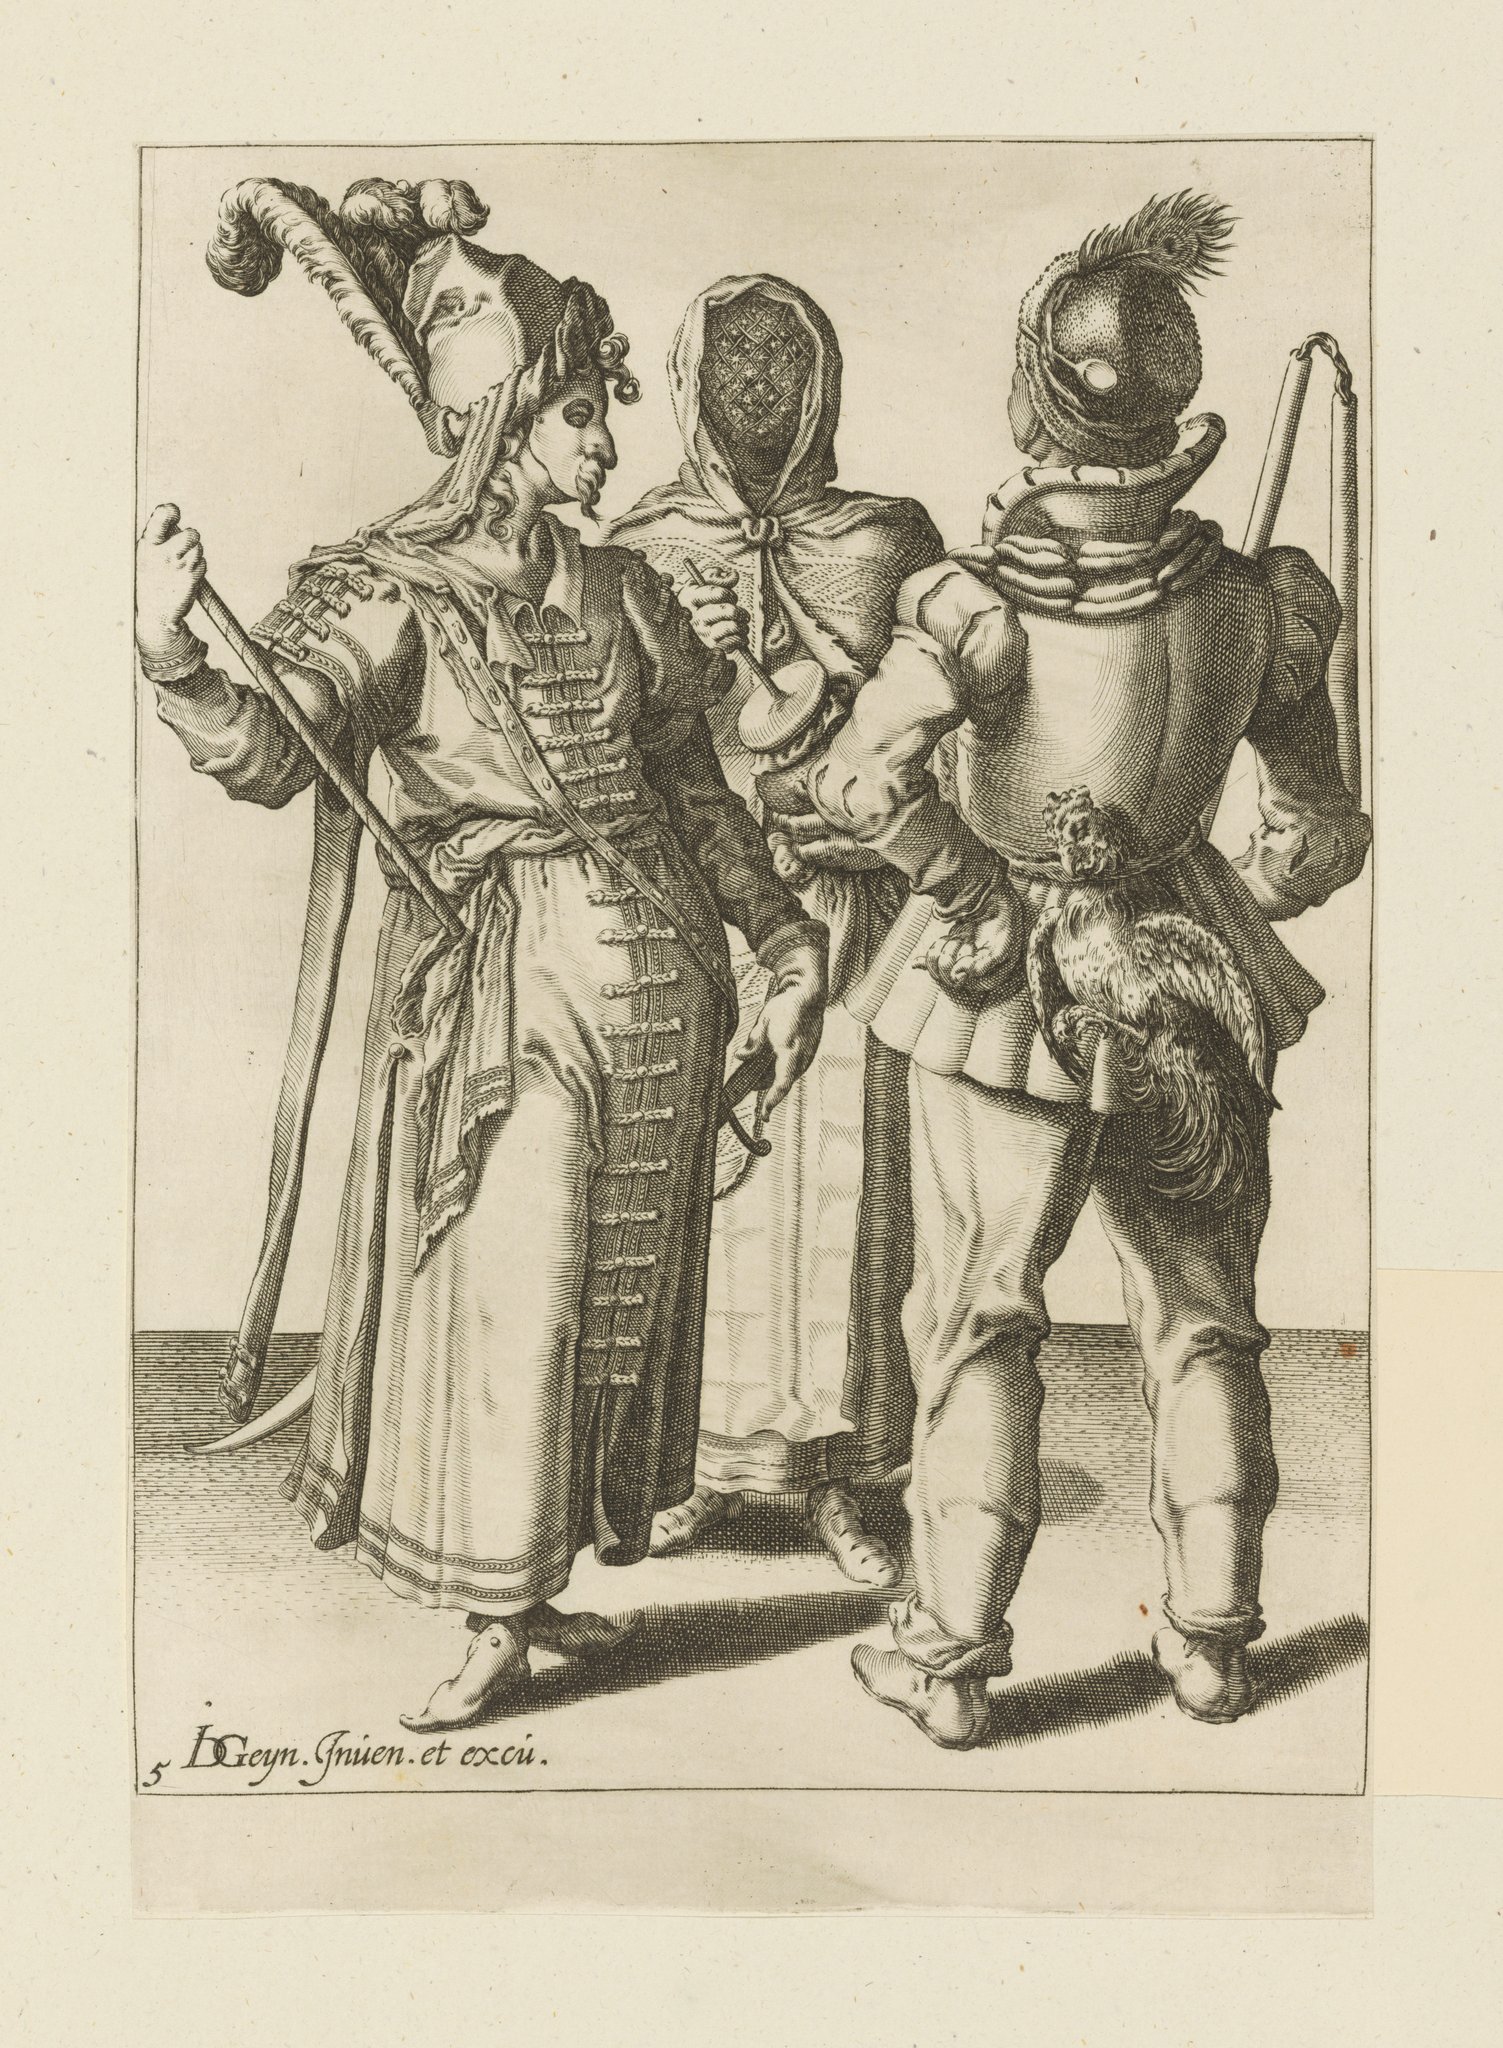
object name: print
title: An Oriental Grandee, A Peasant with a Cock attached to his Belt and a Veiled Woman Playing the Rumbling-Pot, plate 5 from "The Masquerades"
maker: jacques de gheyn (ii)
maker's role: artist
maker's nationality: netherlandish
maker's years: 1565-1629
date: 1595-1596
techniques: engraving